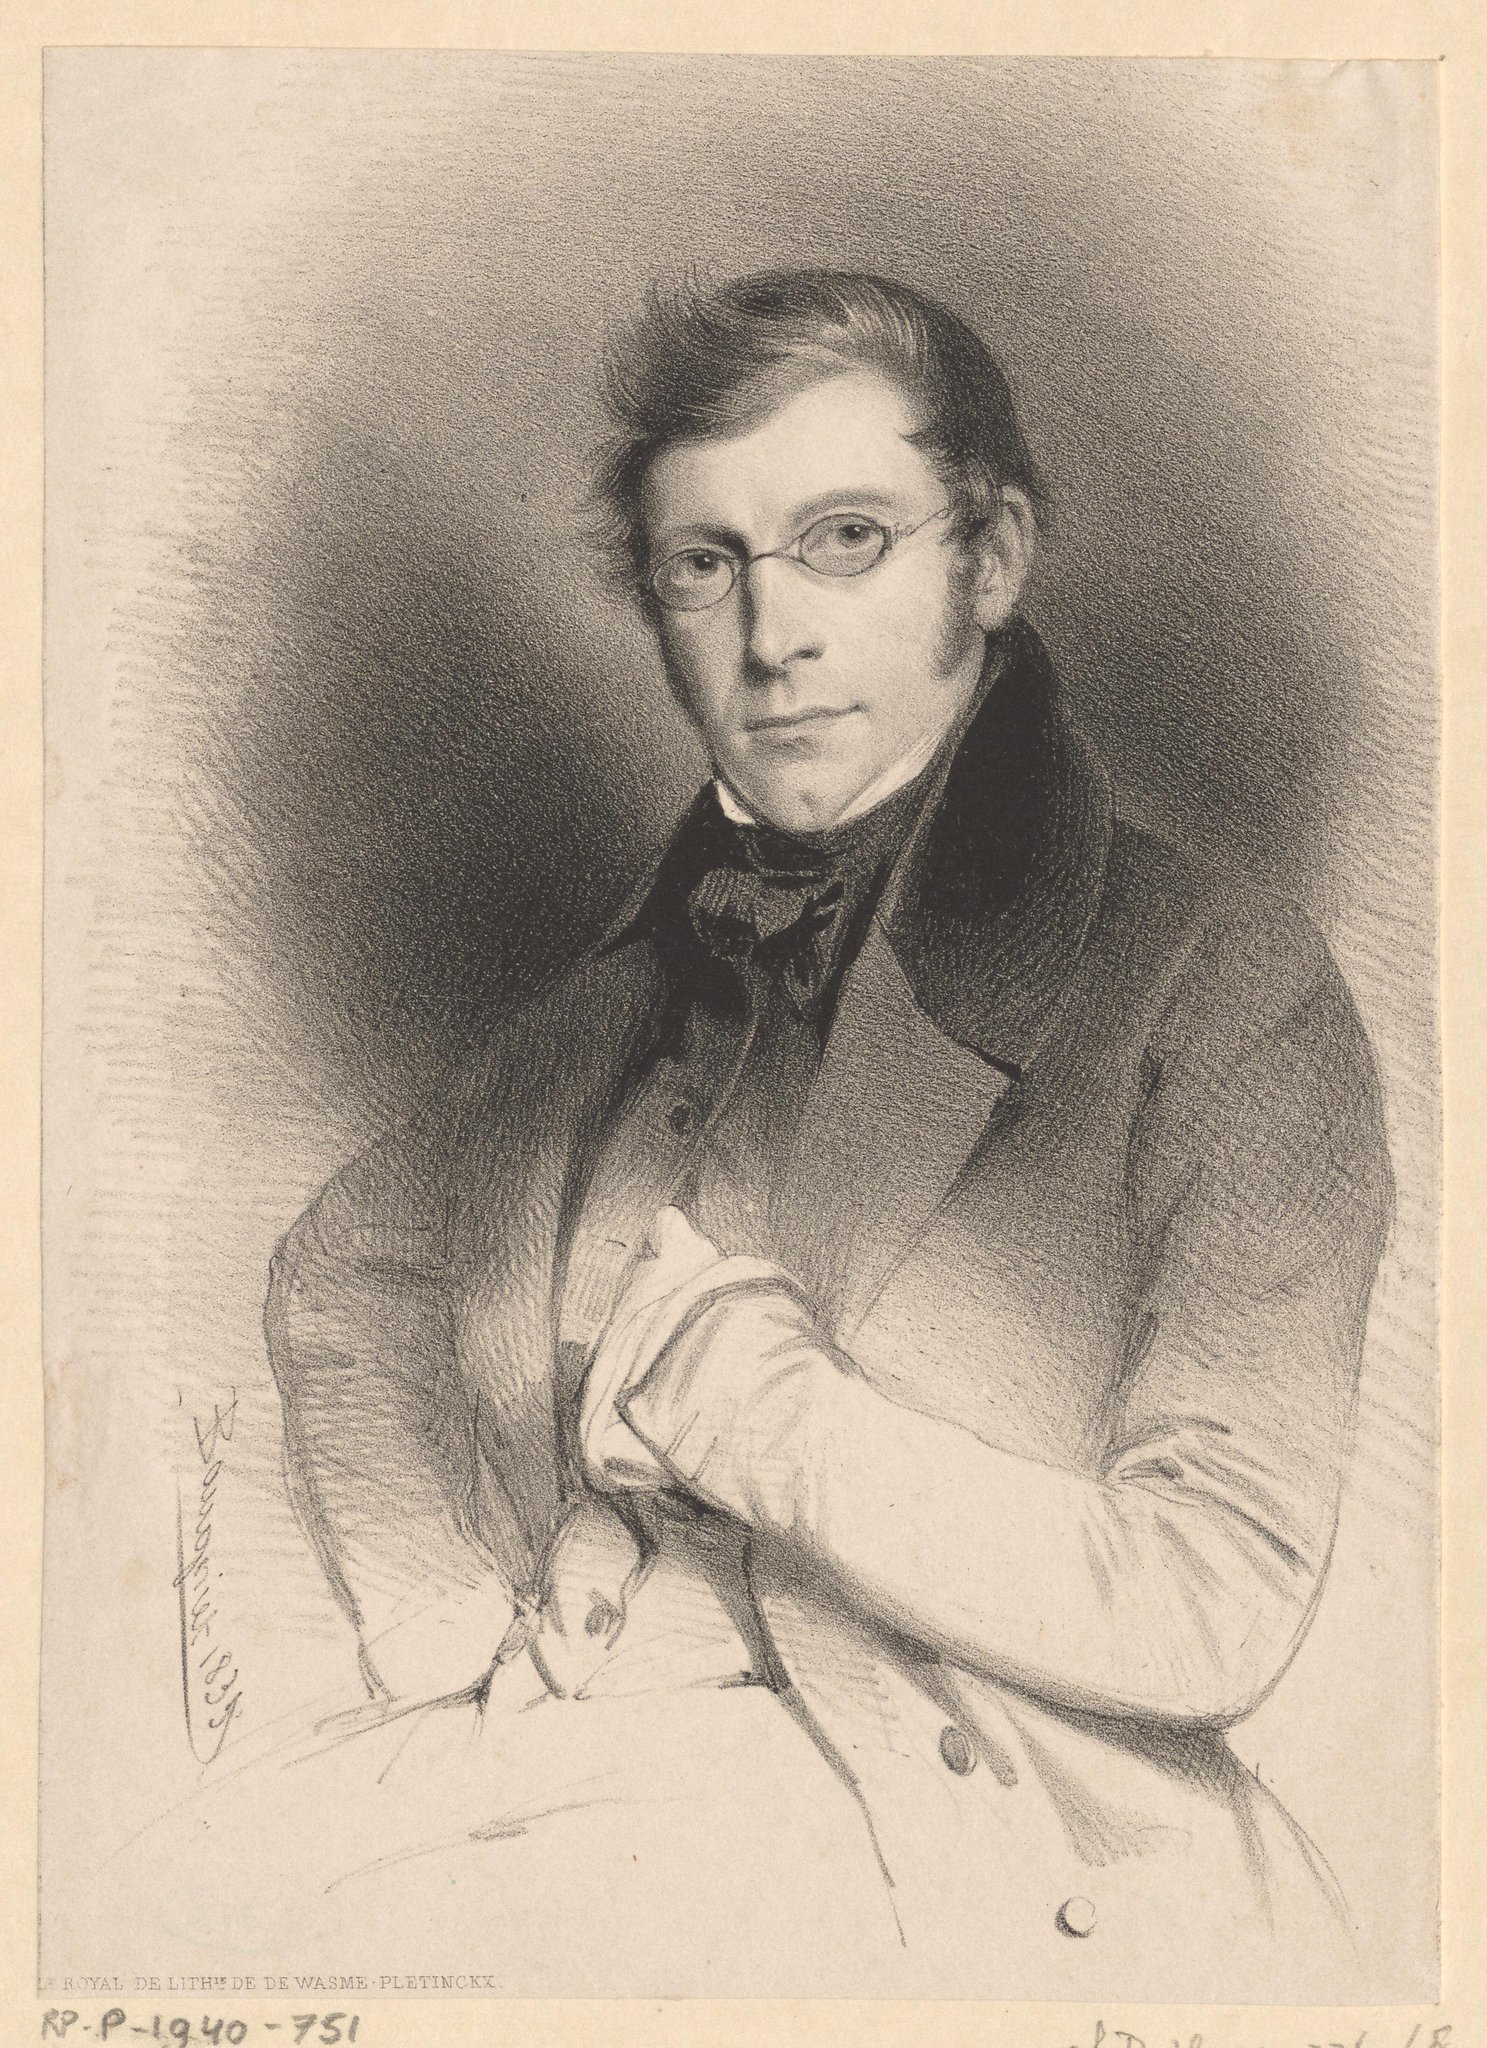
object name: print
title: Portret van P. Bossuet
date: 1835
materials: paper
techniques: lithograph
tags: painter, eyeglasses, spectacles, historical persons, portrait, self-portrait of painter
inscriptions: collector's mark: Lugt 2228, collector's mark: Lugt 2760